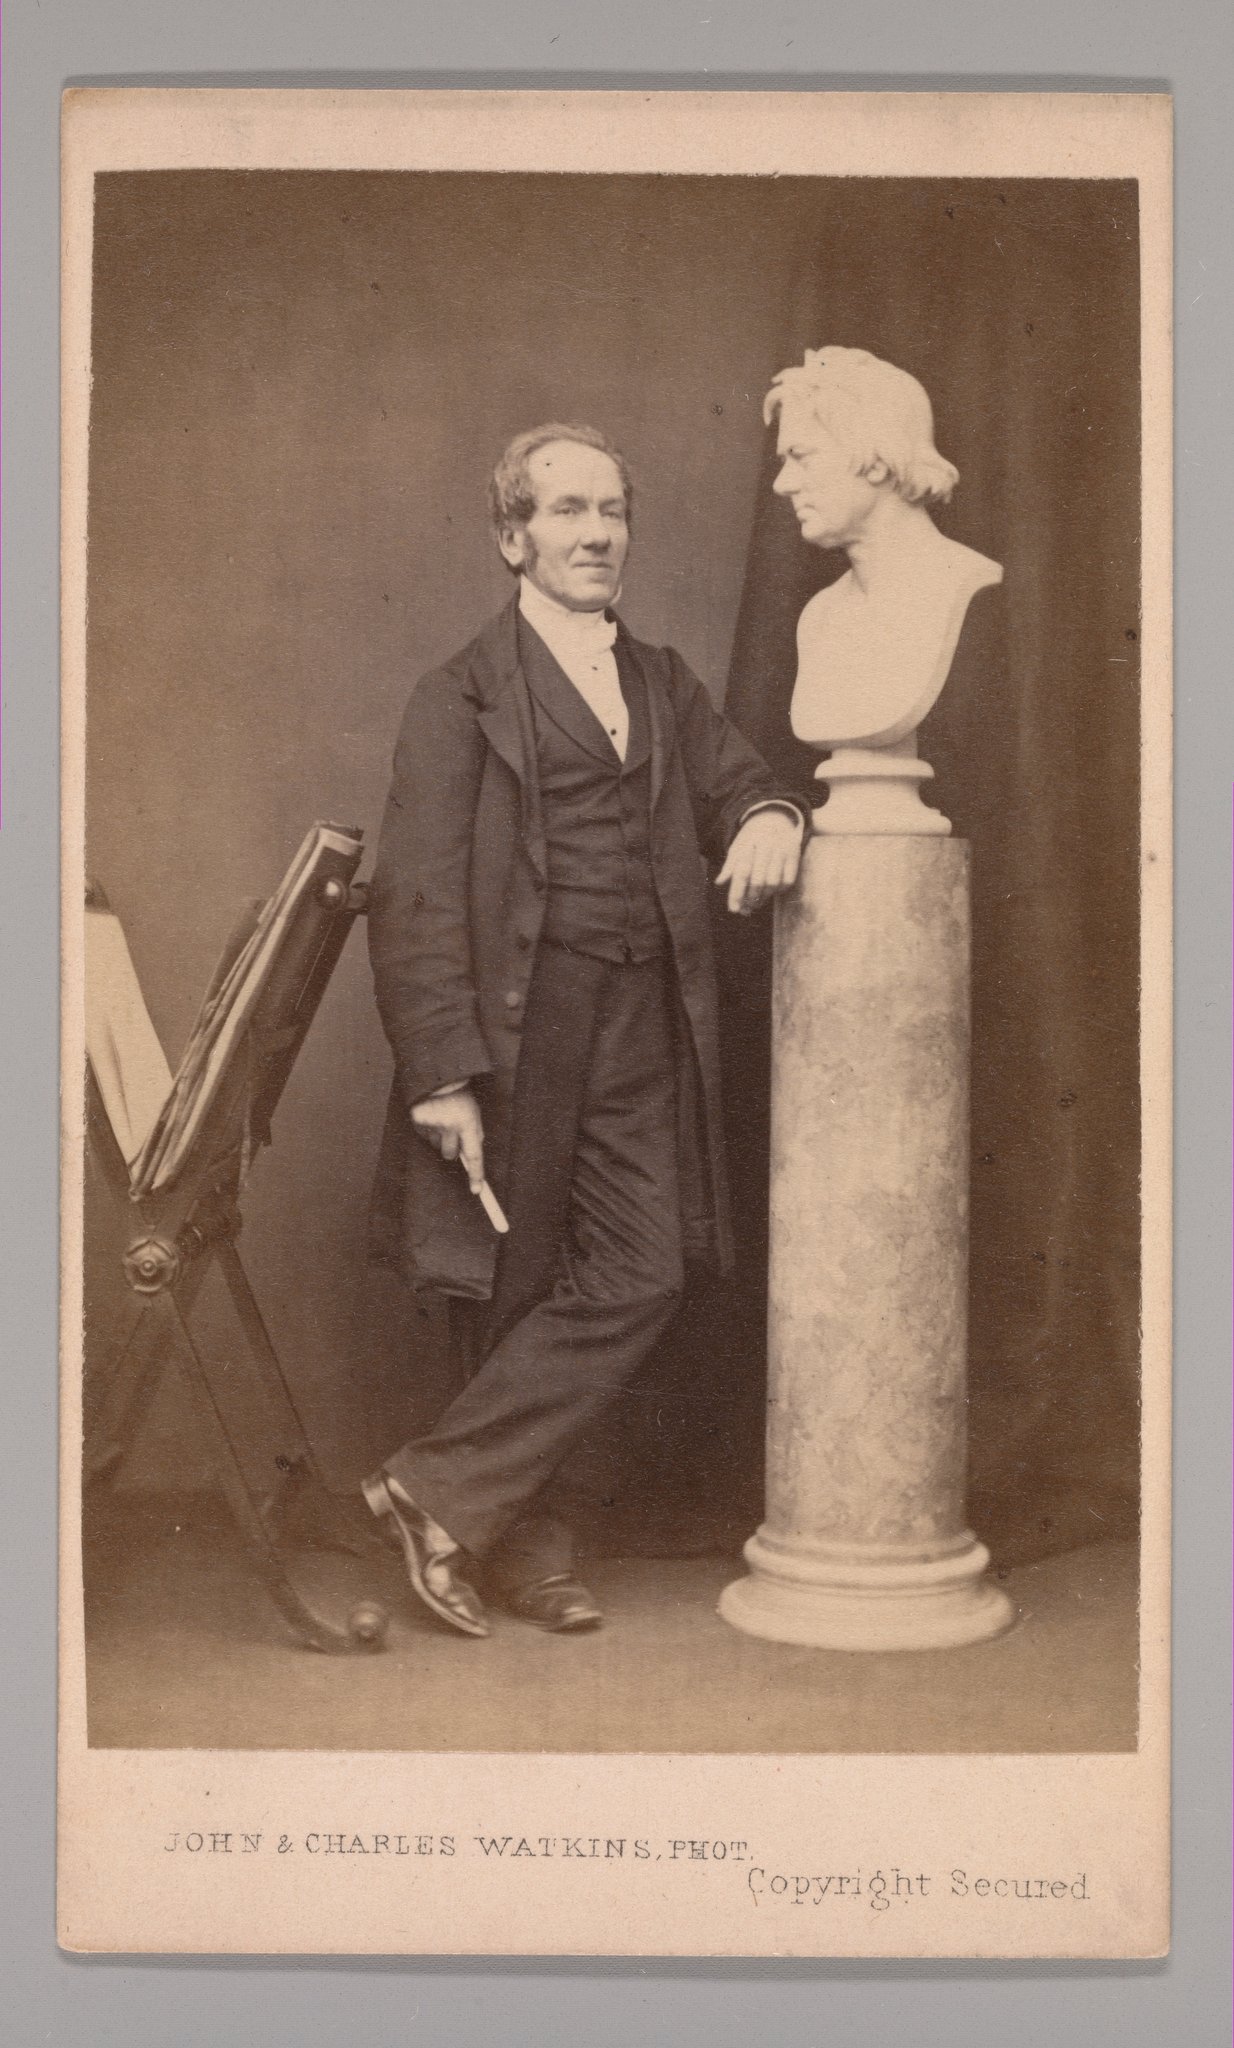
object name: carte de visite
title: [Henry Weekes]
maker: john and charles watkins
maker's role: photography studio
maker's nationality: british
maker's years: 1840-1875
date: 1860-1869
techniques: albumen silver print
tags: sculpture,men,portraits